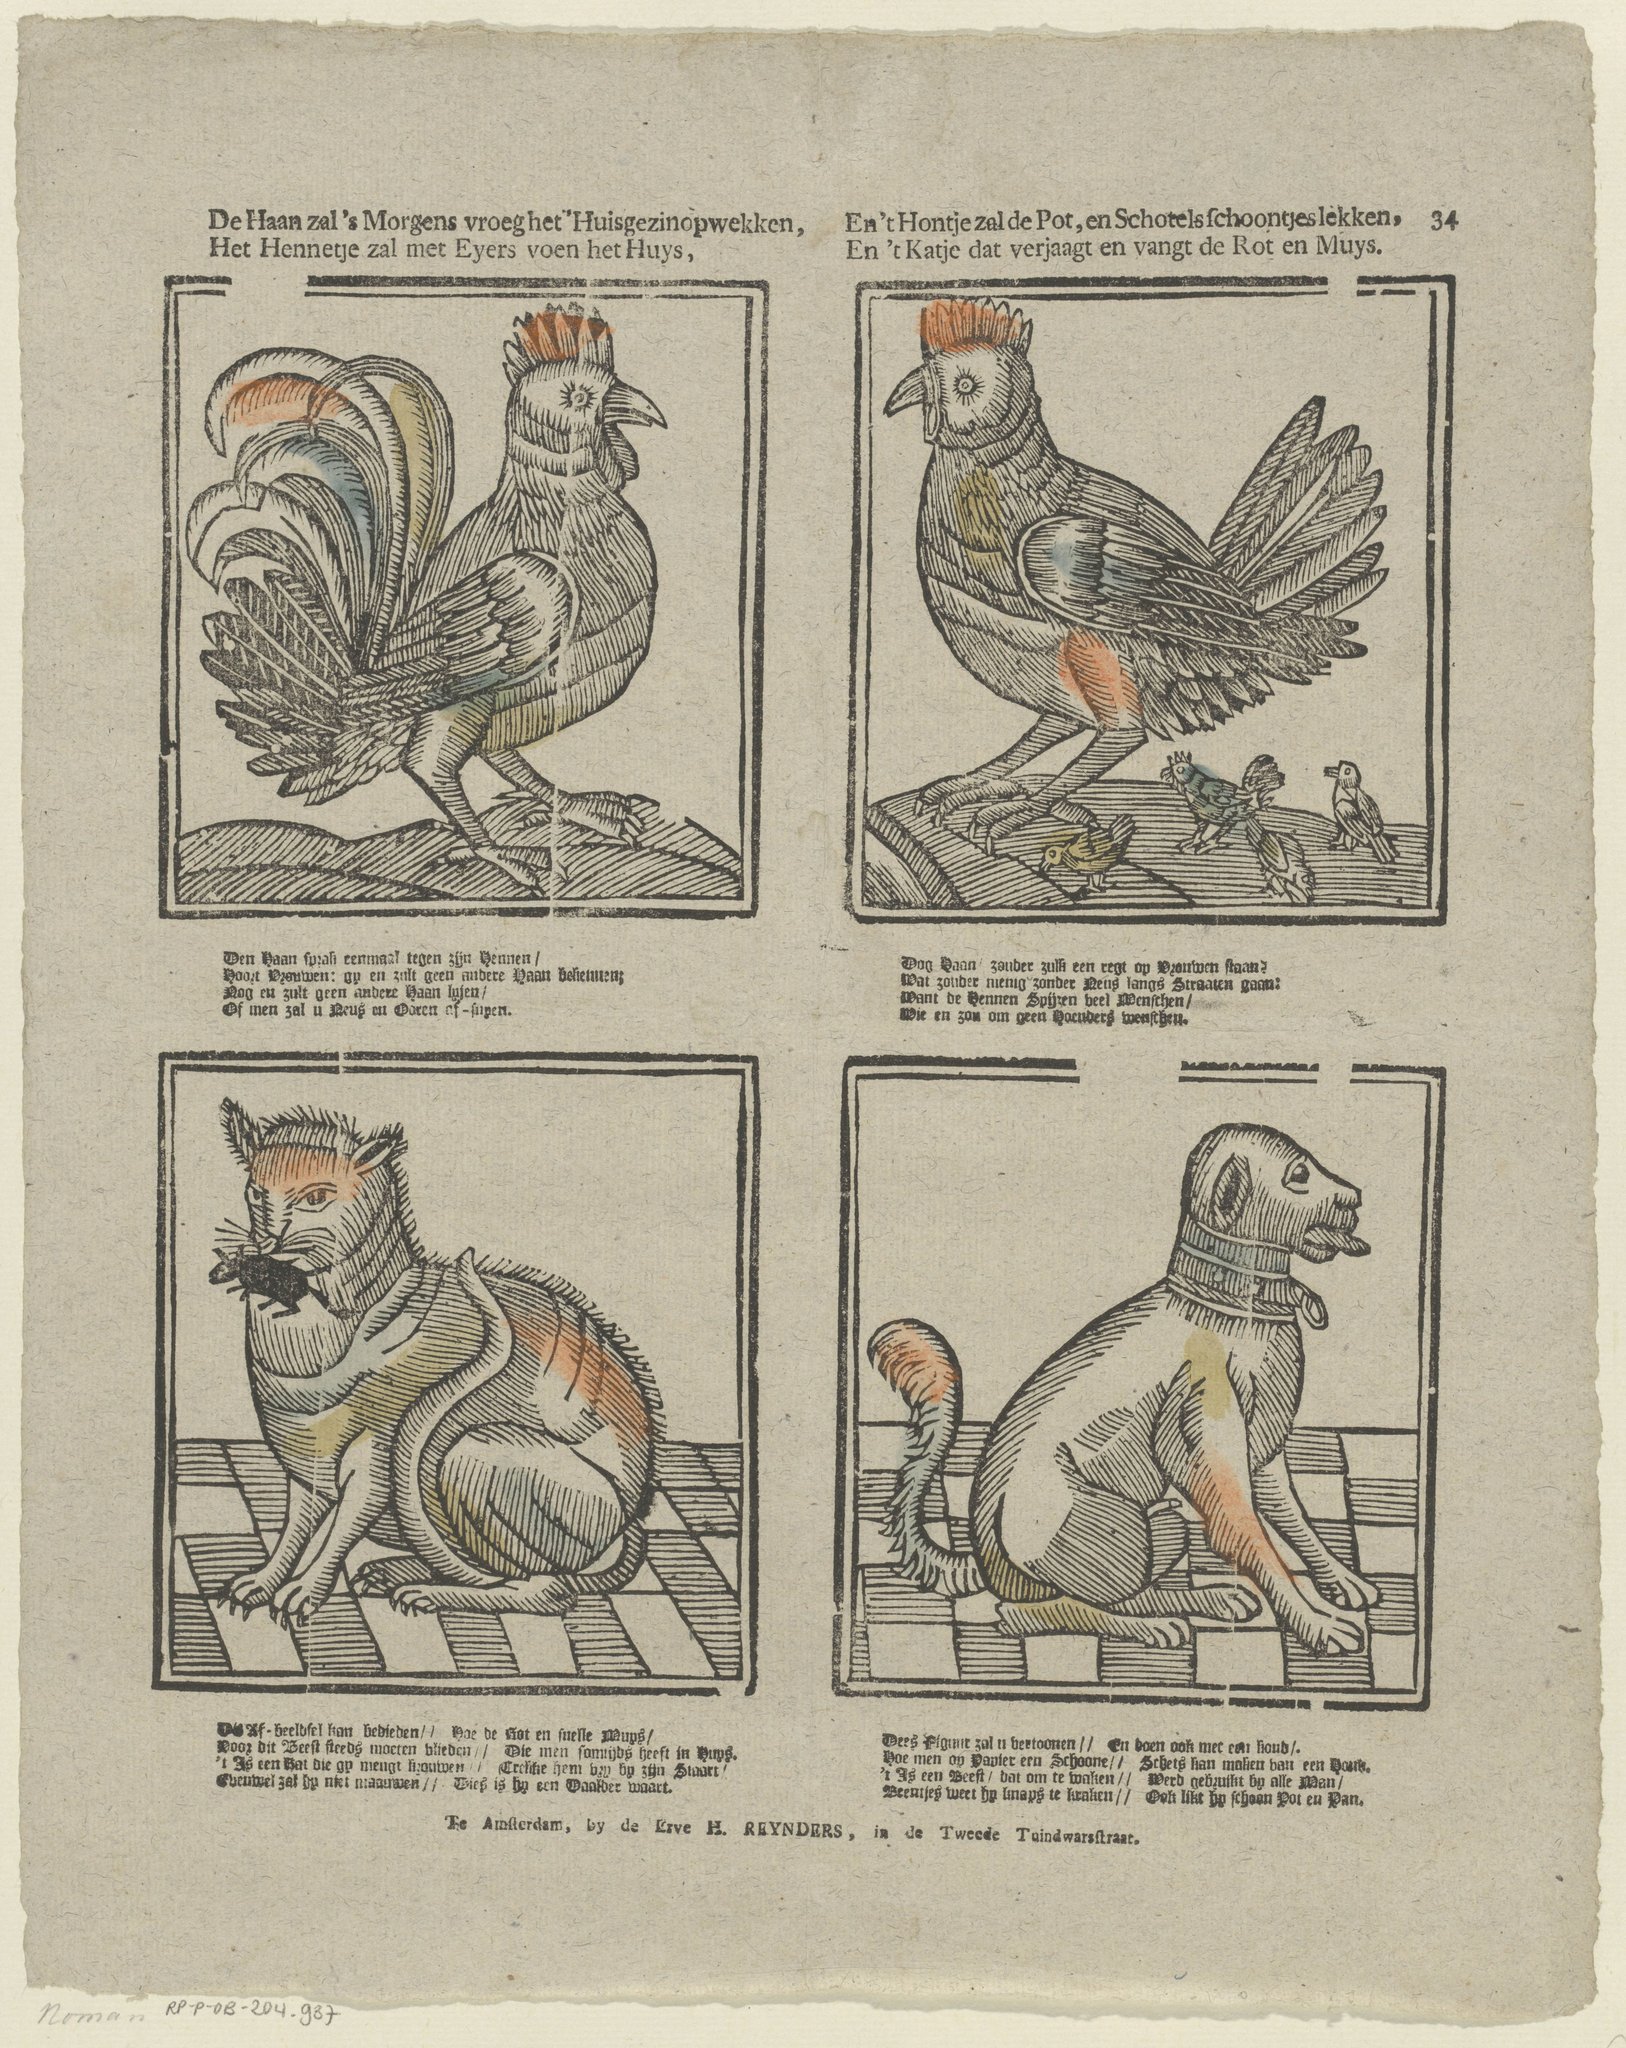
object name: print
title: De haan zal 's morgens vroeg het huisgezinopwekken, / Het hennetje zal met eyers voen het huys, / En 't hondje zal de pot, en schotels schoontjes lekken, / En 't katje dat verjaagt en vangt de rot en muys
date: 1806-1854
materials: paper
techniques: colour, letterpress printing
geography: zaltbommel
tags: animals, cat, fowl (cock, hen, chicken, etc.), dog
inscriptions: collector's mark: Lugt 2760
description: Blad met 4 voorstellingen van dieren: een haan, een kip, een kat en een hond. Onder elke afbeelding een vers. Genummerd rechtsboven: 34.